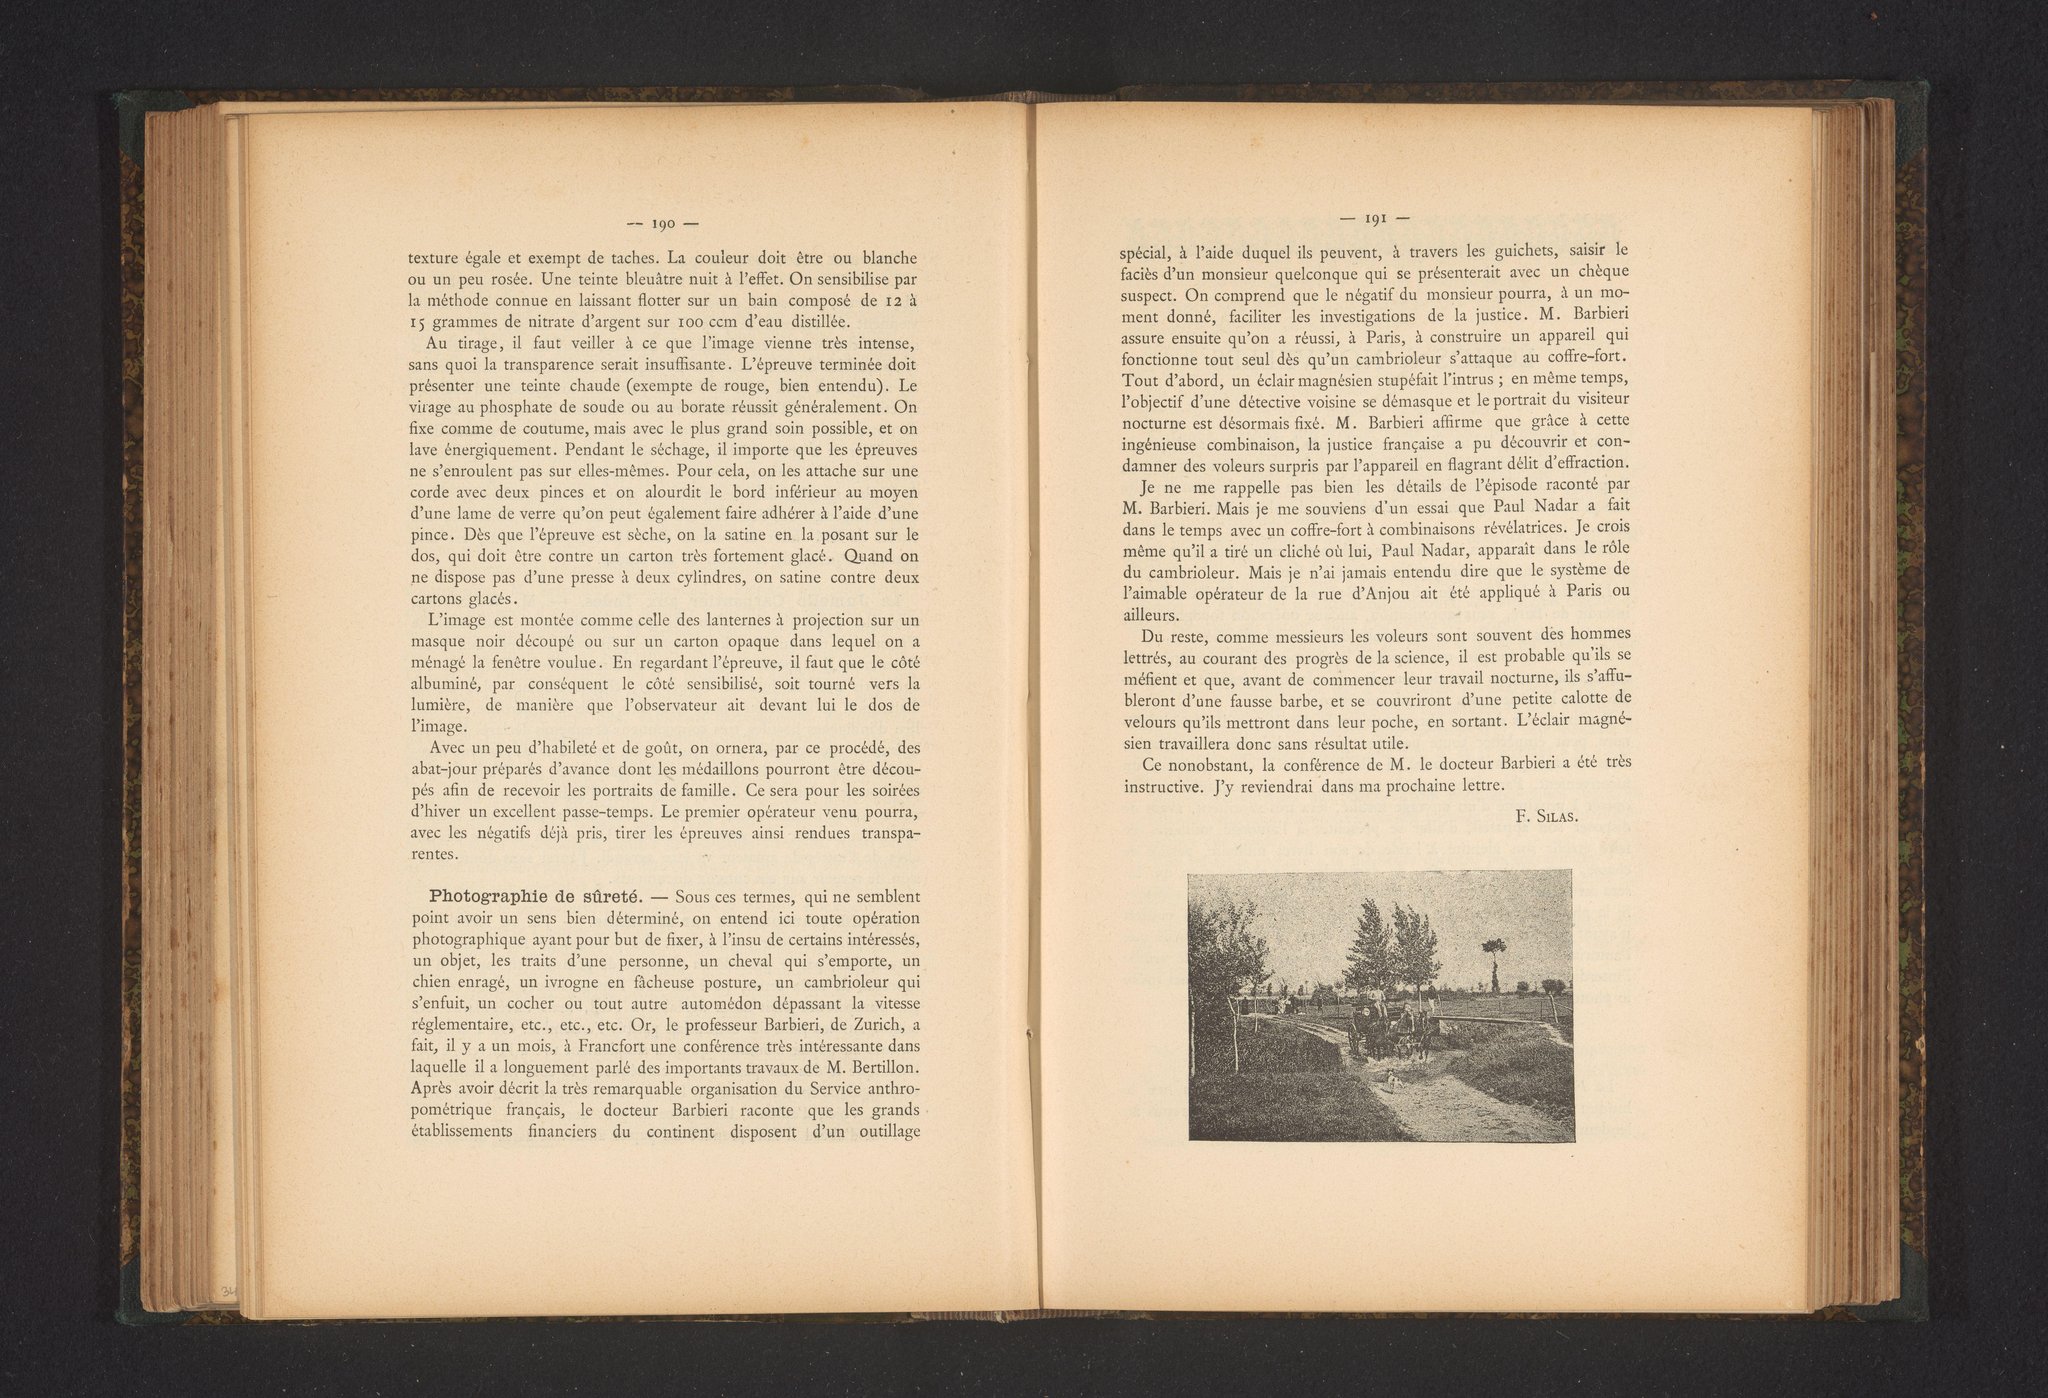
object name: photomechanical print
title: Man op een wagen met twee paarden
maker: Anonymous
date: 1890-1895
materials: paper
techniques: photograph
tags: adult man, horse, four-wheeled vehicle drawn by two animals